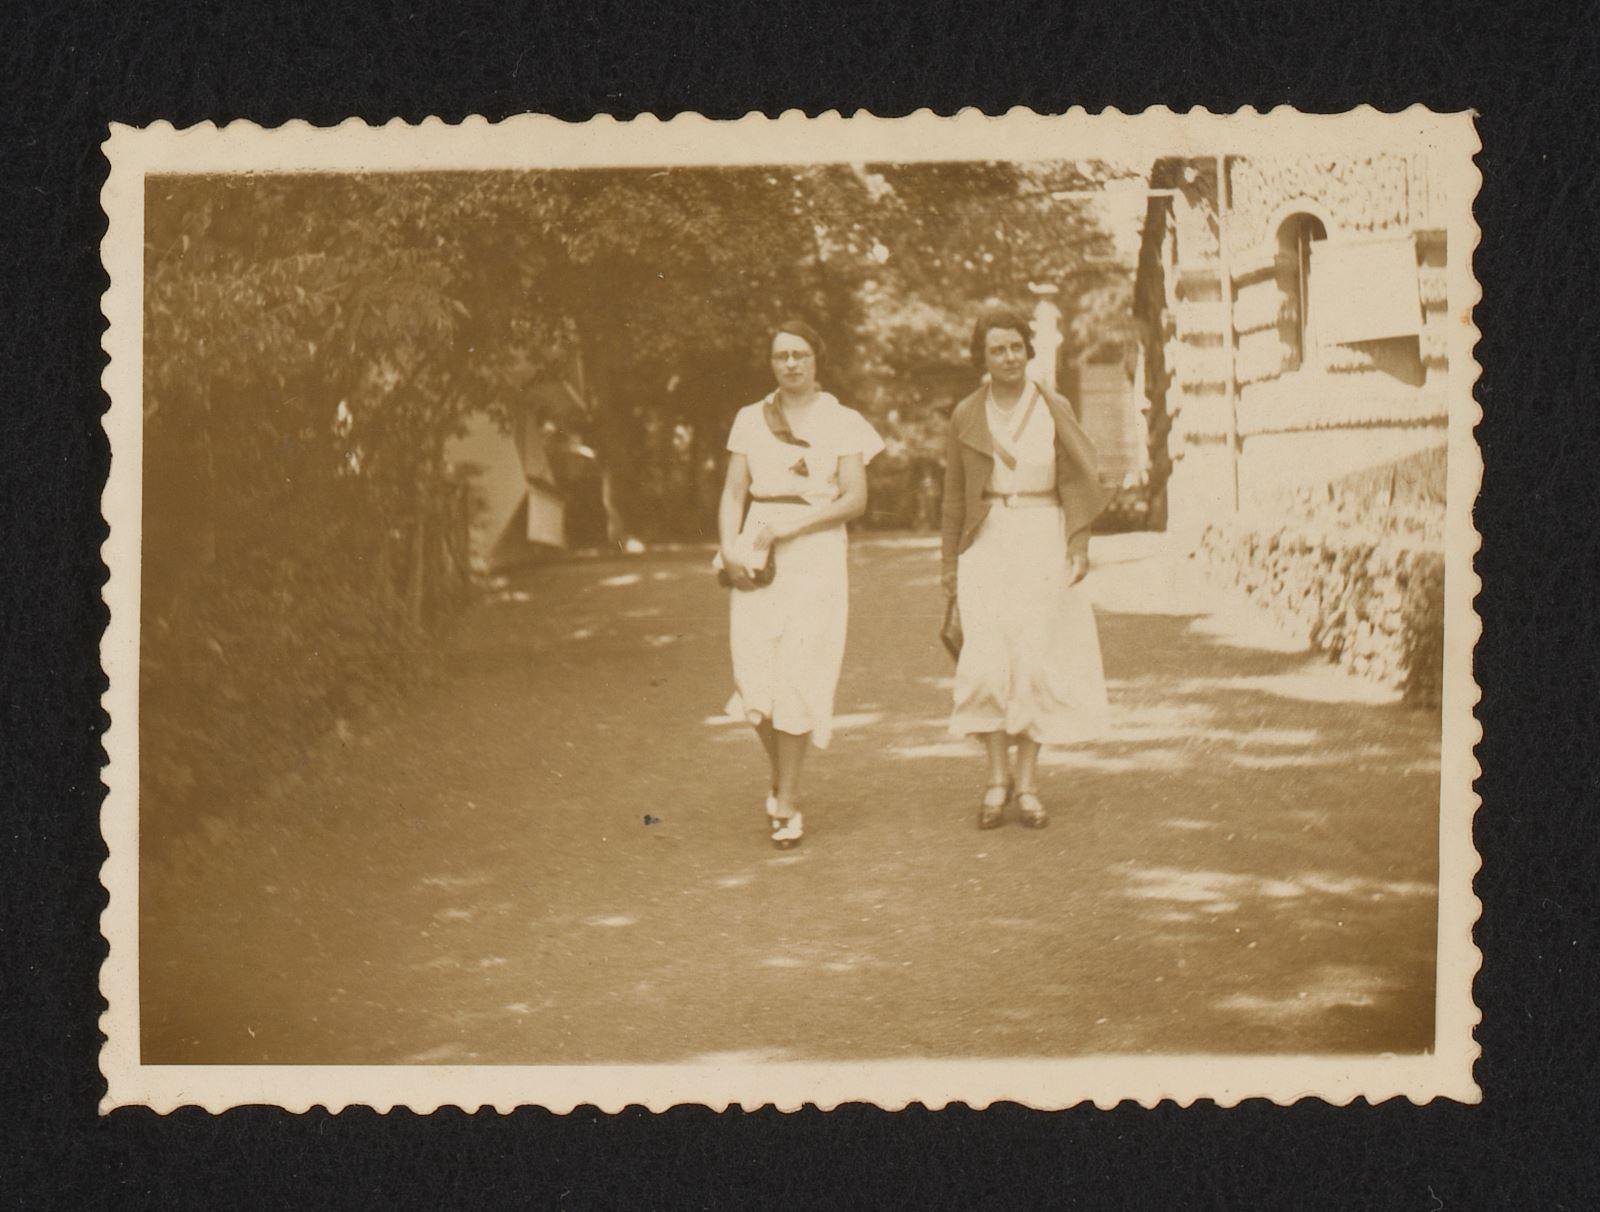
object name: album leaf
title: Twee vrouwen lopend over een schaduwrijke straat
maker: Anonymous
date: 1910-1930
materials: paper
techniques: gelatin silver print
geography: france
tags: adult woman, shadow, walking, france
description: Over de foto is een ander negatief afgedrukt van een voorstelling van bomen.